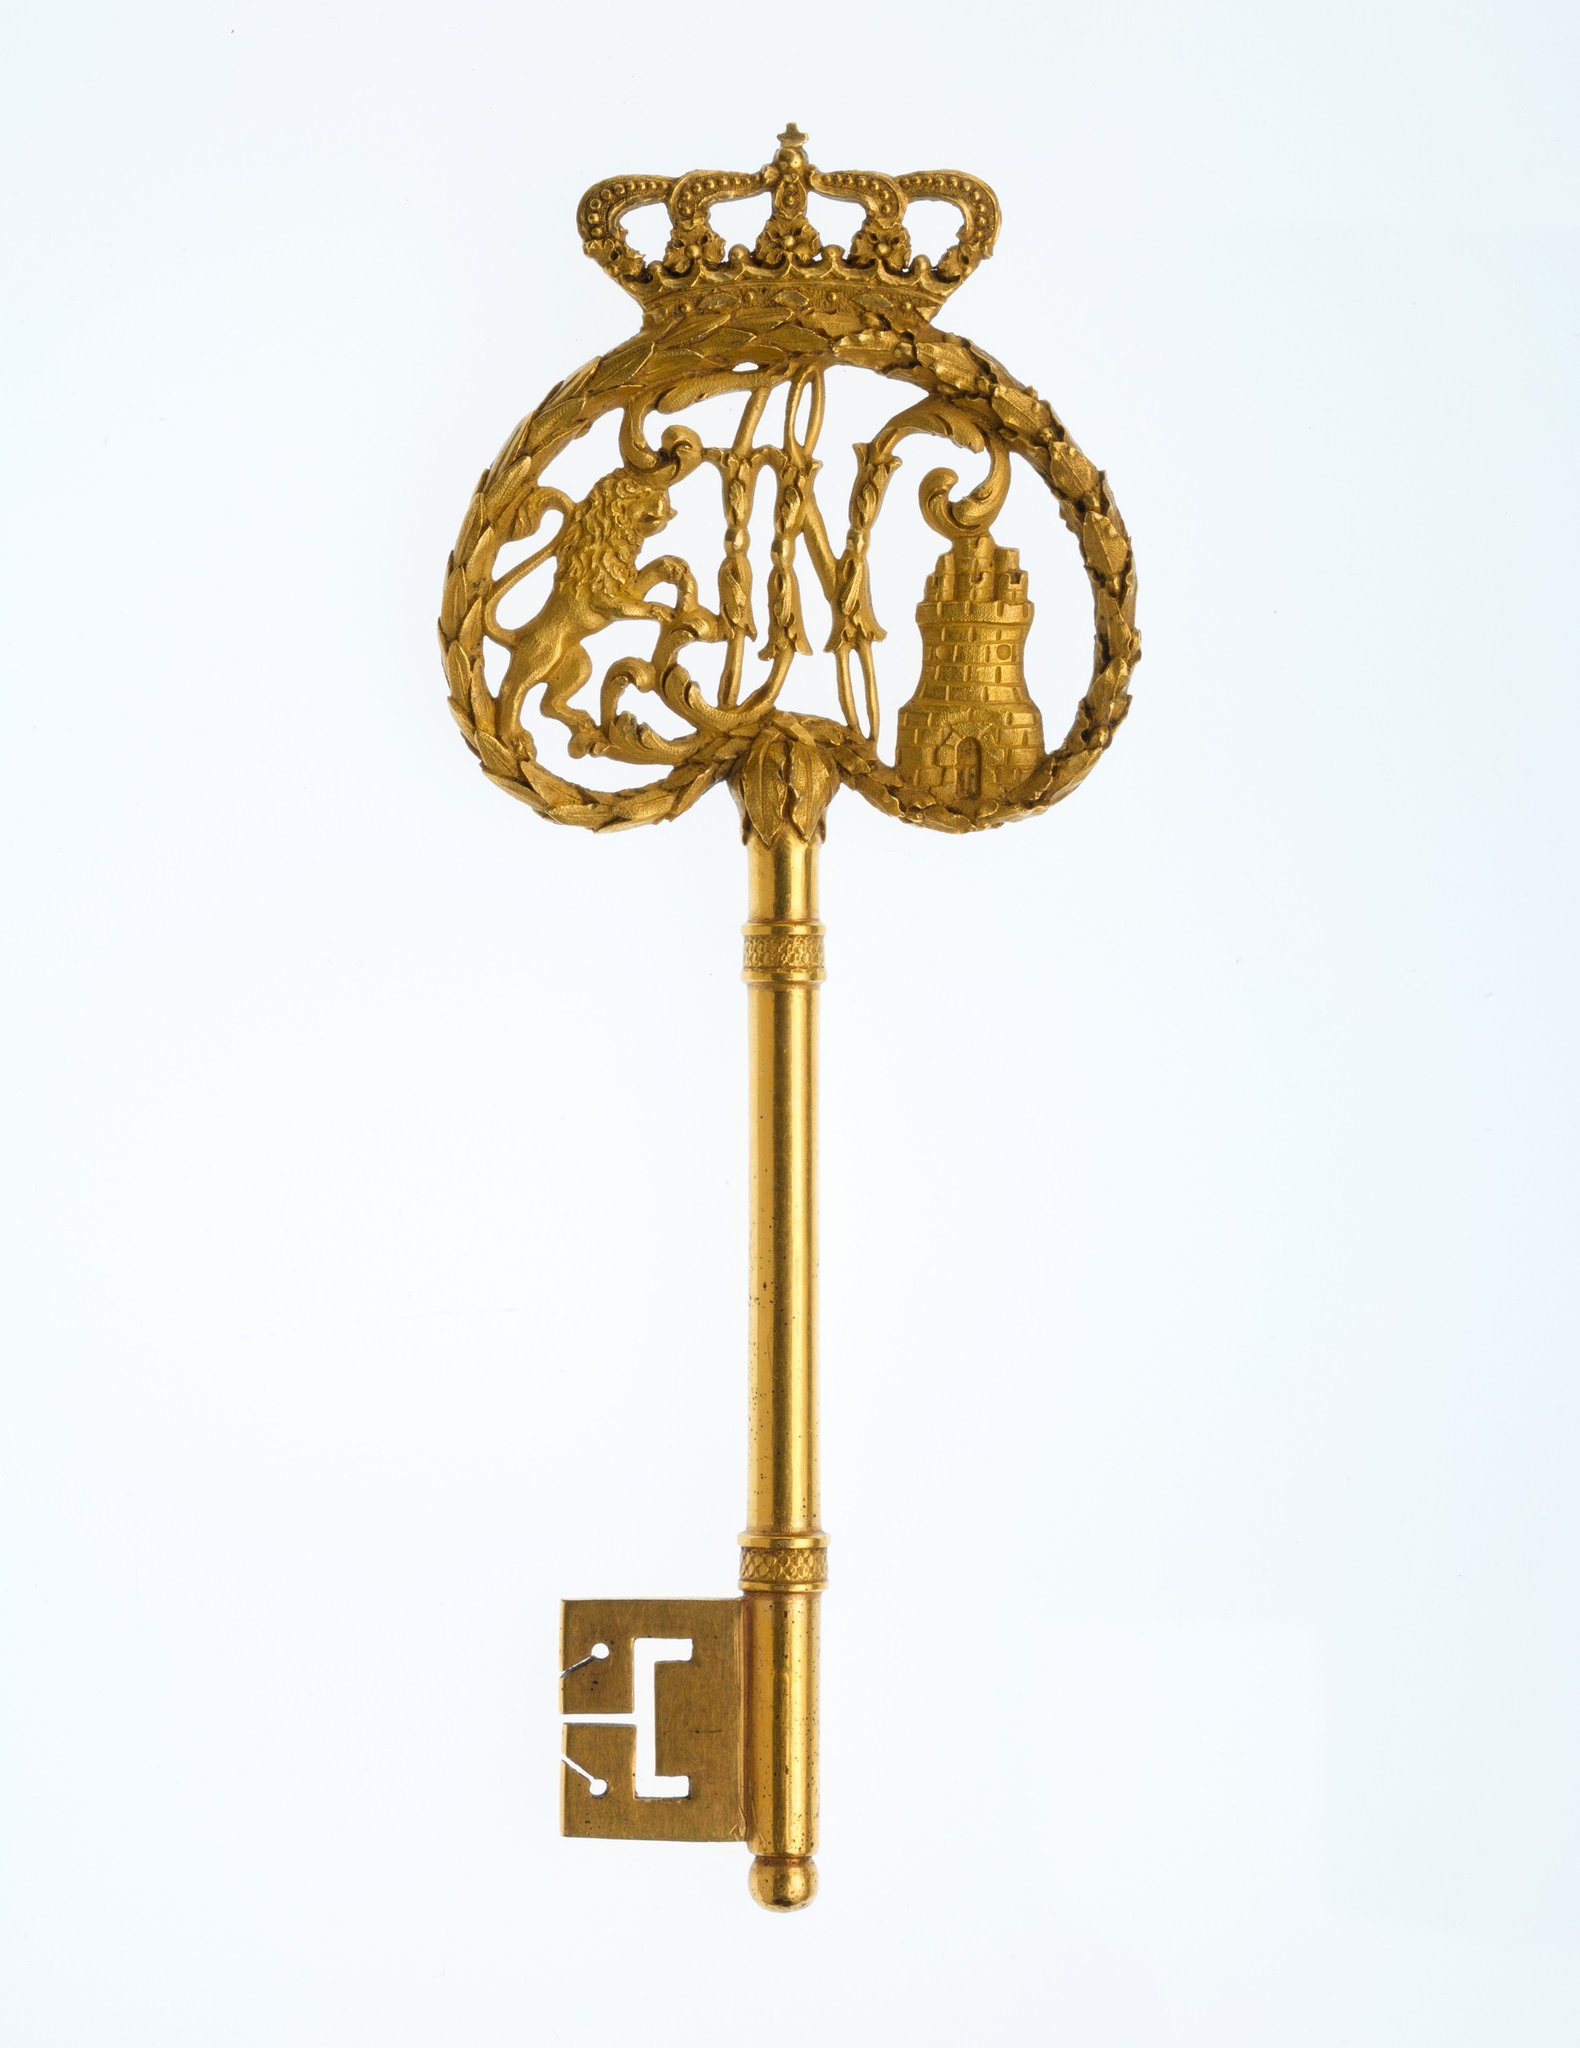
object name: key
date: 1808-1813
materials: gilt bronze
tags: lions